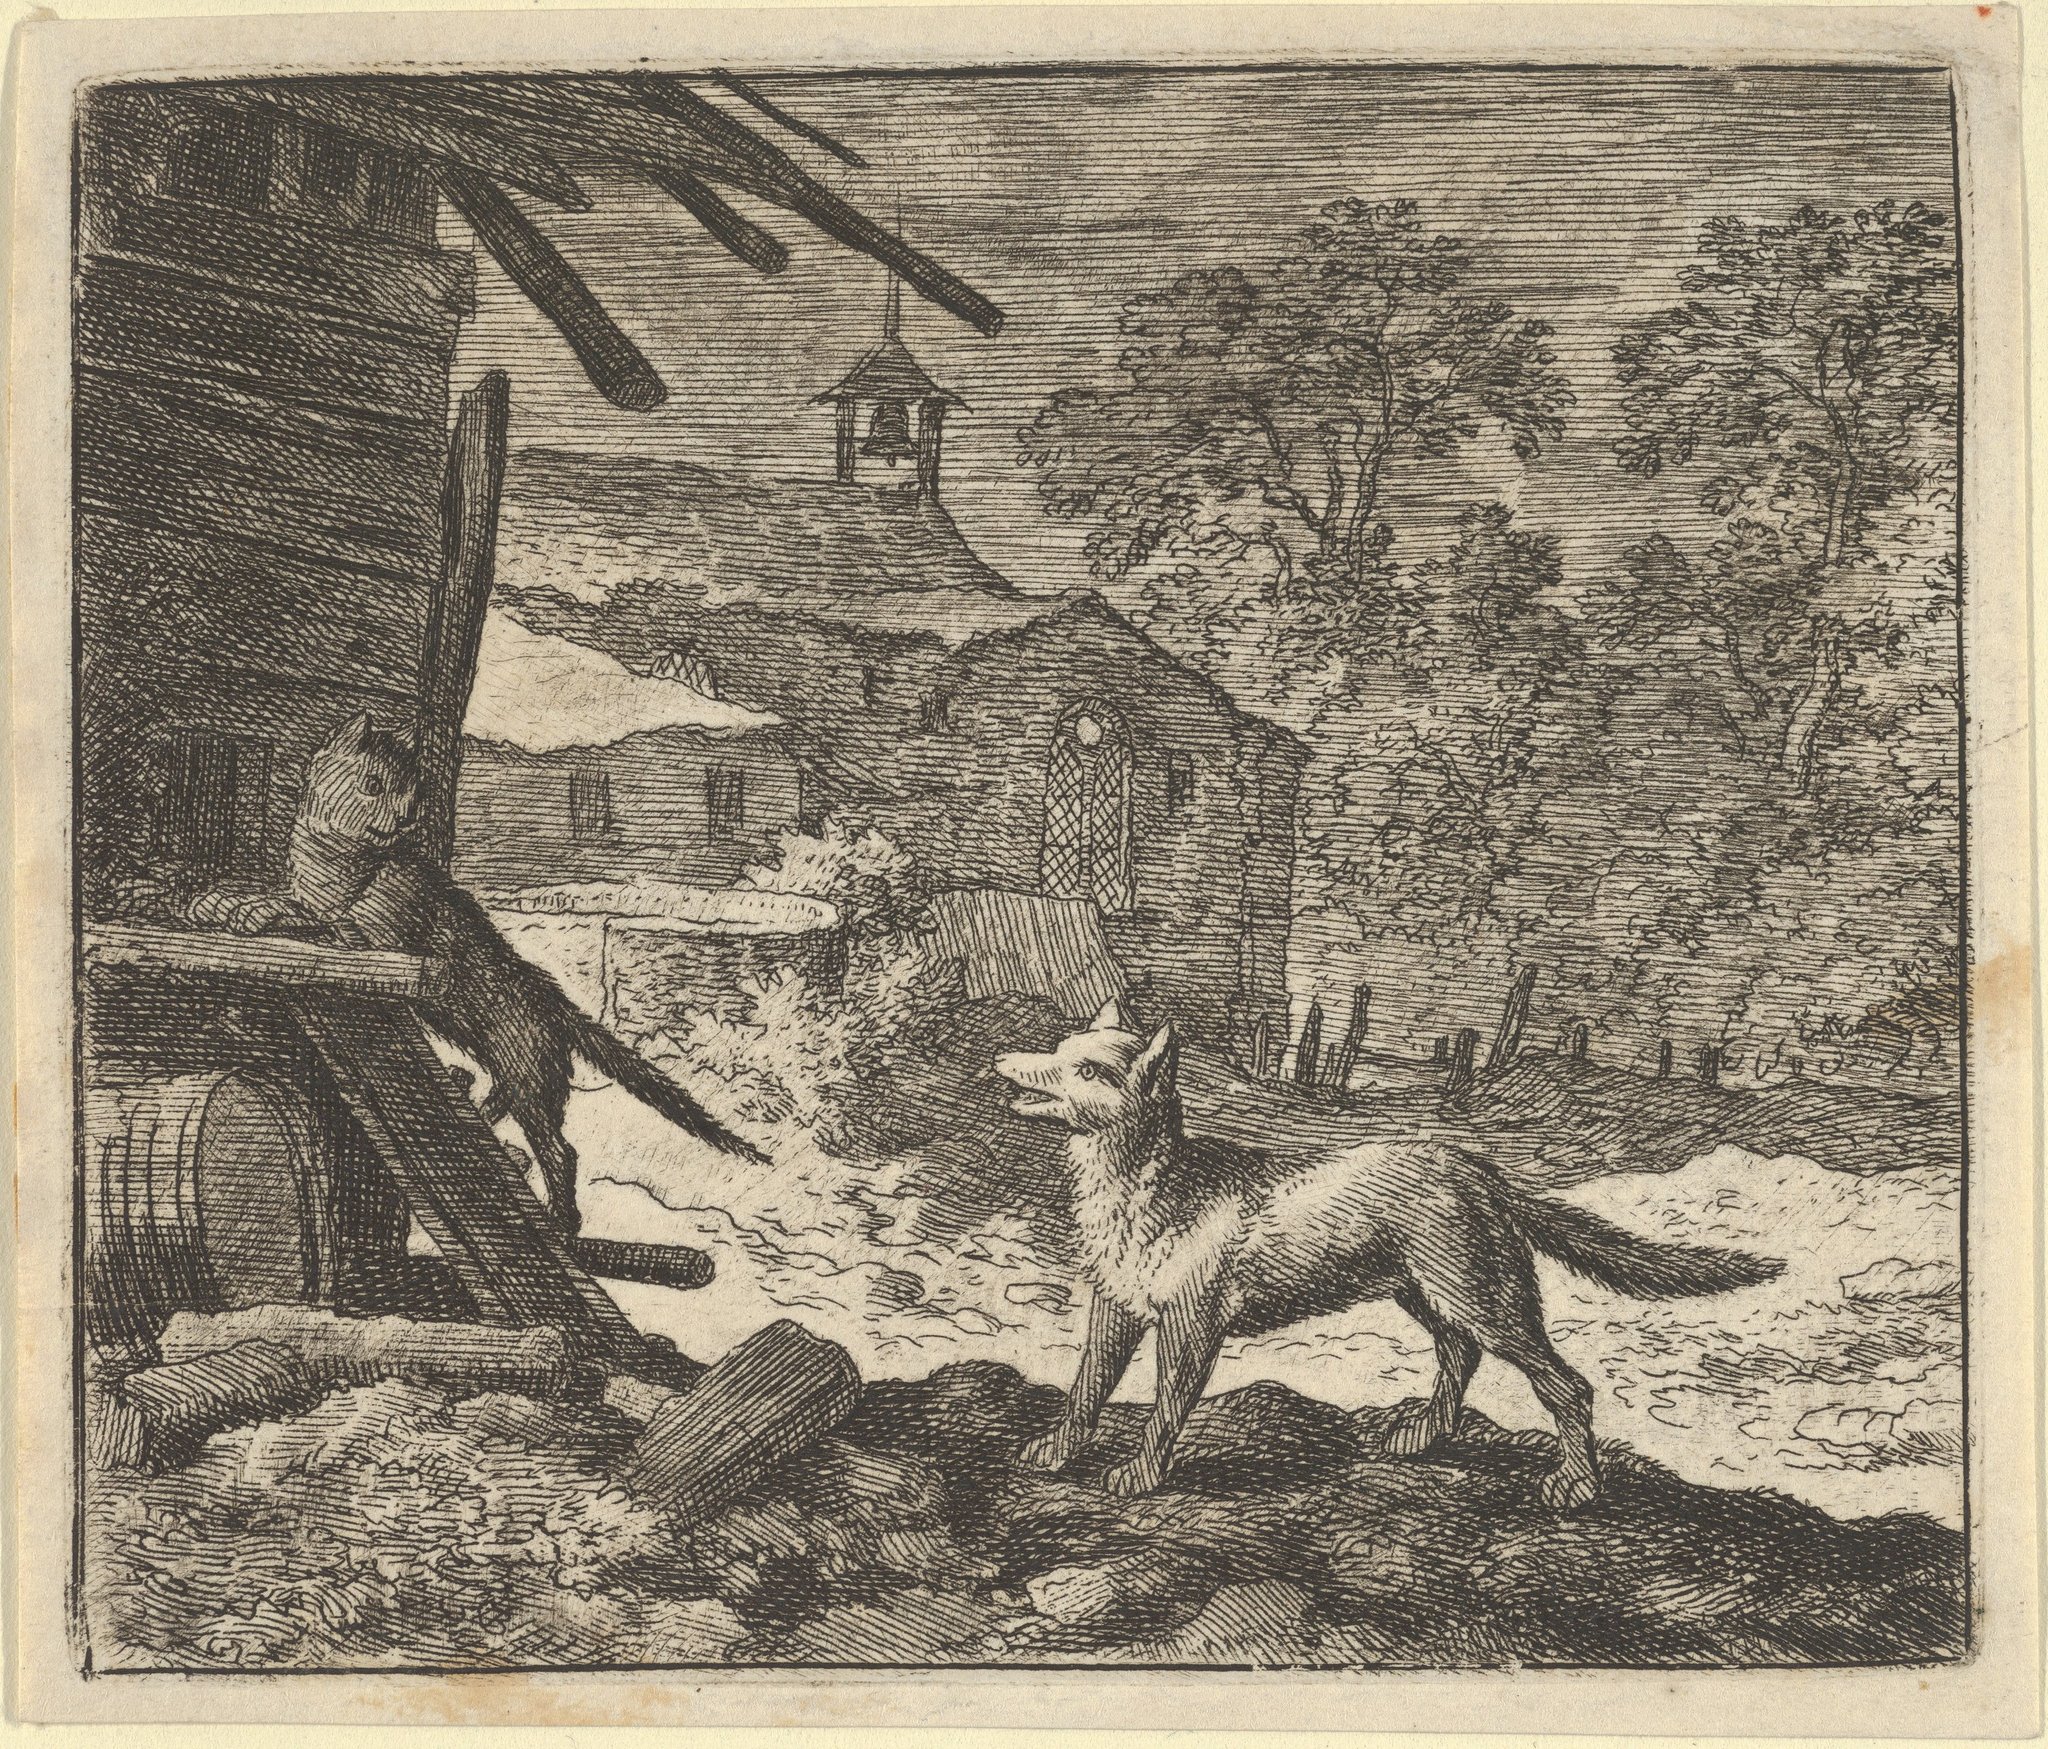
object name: print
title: The Cat Climbs a Barn from Hendrick van Alcmar's Renard The Fox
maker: allart van everdingen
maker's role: artist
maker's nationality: dutch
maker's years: 1621-1675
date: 1650-1675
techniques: engraving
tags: barns,cats,foxes